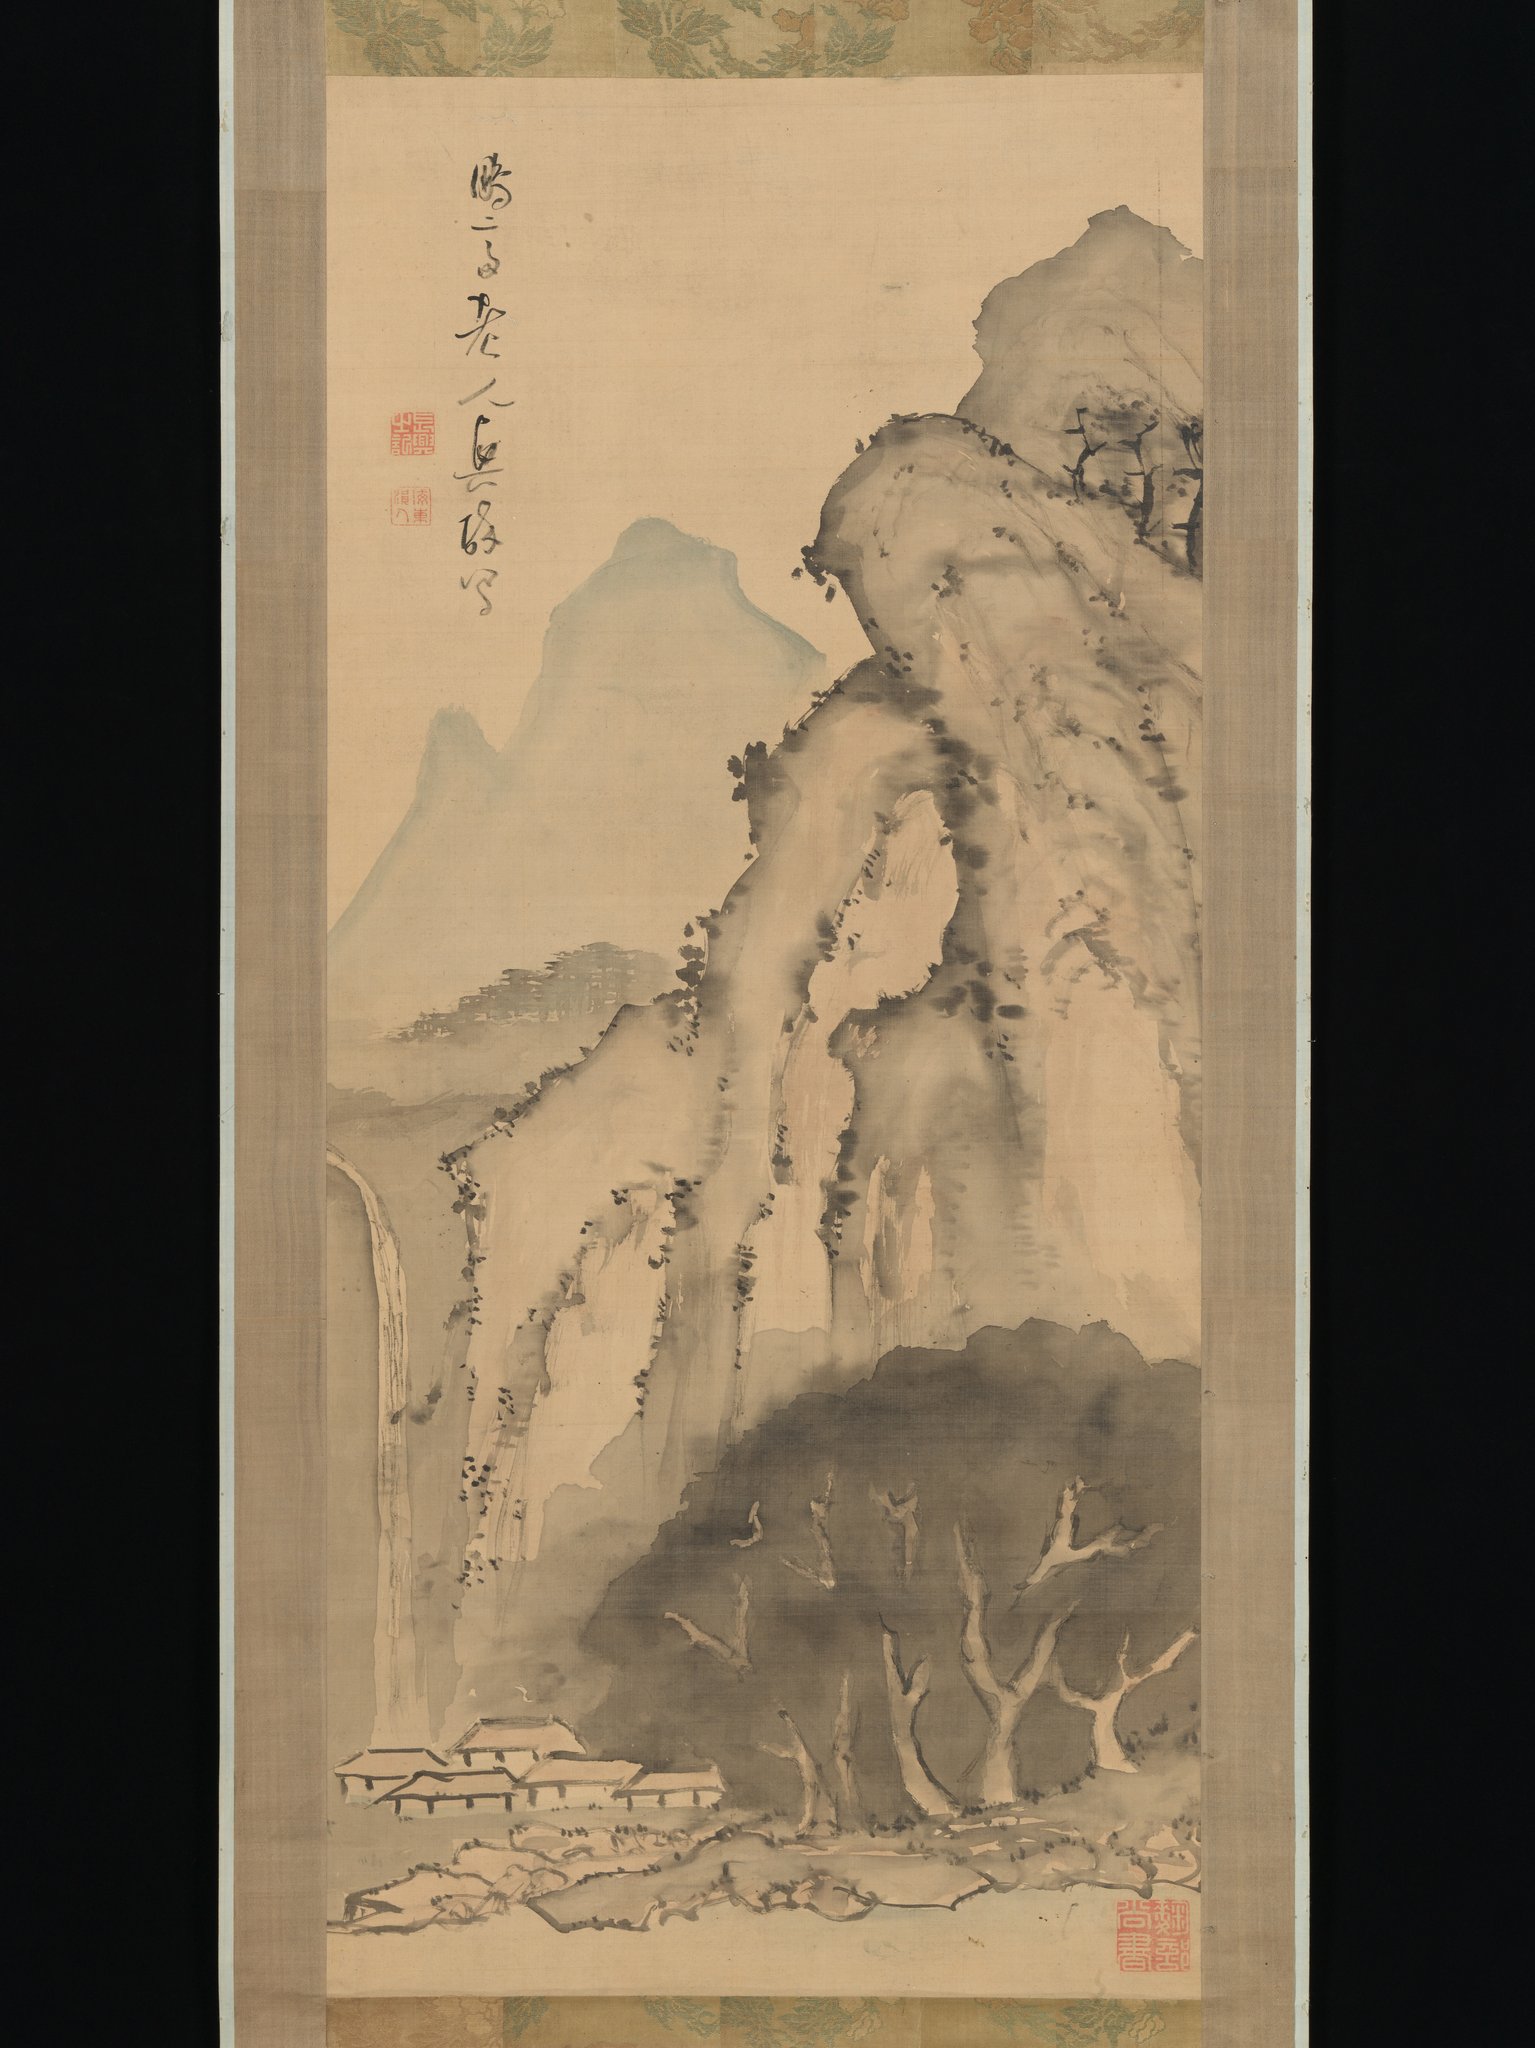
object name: hanging scroll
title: Landscape with Waterfall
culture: japanese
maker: kameda bōsai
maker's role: artist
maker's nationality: japanese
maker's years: 1752-1826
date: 1817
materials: ink, silk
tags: waterfalls,mountains,landscapes